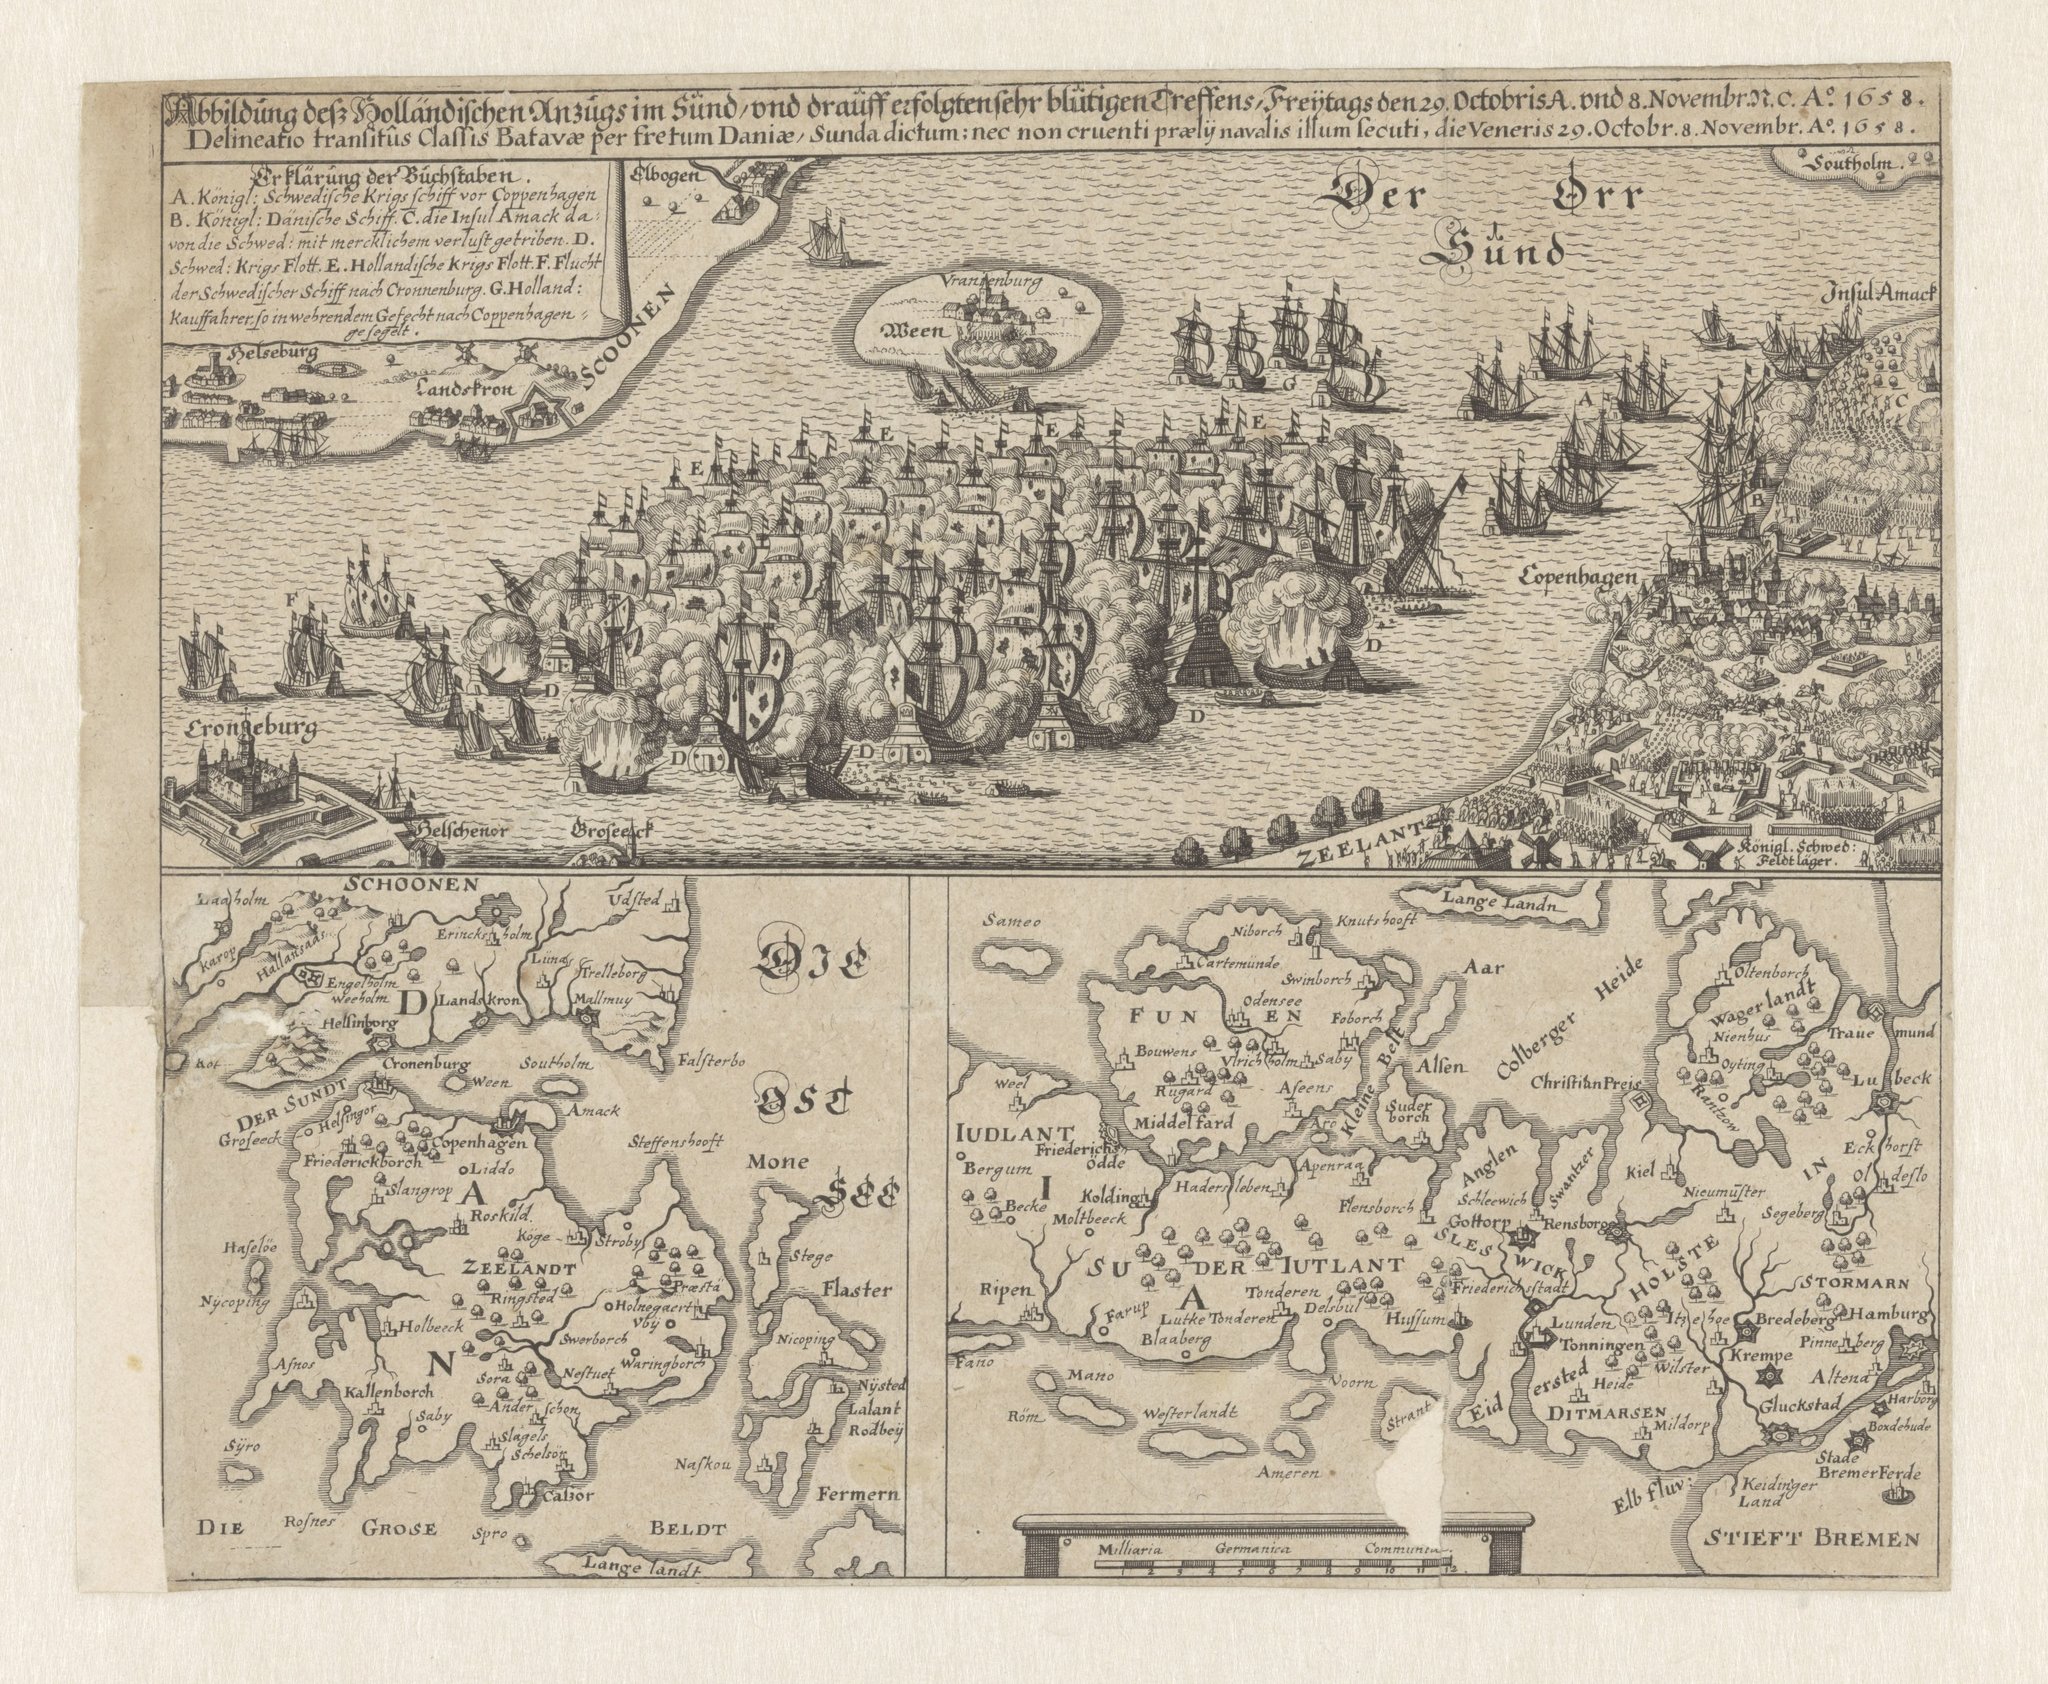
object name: print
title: Abbildung dess Holländischen Anzugs im Sündt / und drauff erfolgten sehr blütigen Treffens, Freijtags den 29. Octobris A. und 8 Novembr. ... Ao. 1658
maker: Anonymous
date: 1658-1699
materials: paper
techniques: etching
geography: germany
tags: jacob baron van wassenaer heer van obdam, battle (+ sailing-ships), copenhagen (city)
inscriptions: collector's mark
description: Zeeslag in de Sont tussen Helsingør, Helsingborg en Kopenhagen, op 8 November 1658. De Staatse vloot o.l.v. Jacob van Wassenaer Obdam schoot daarbij de Deense koning Frederik III te hulp tegen de Zweden onder leiding van koning Karel X Gustaaf. De Nederlanders waren succesvol en dwongen de Zweden hun belegering van Kopenhagen te beëindigen. Voorstelling in drie delen. Bovenaan de zeeslag met de legenda A-G in het Duits, daaronder twee kaarten van de Sont en Sleeswijk-Holstein.